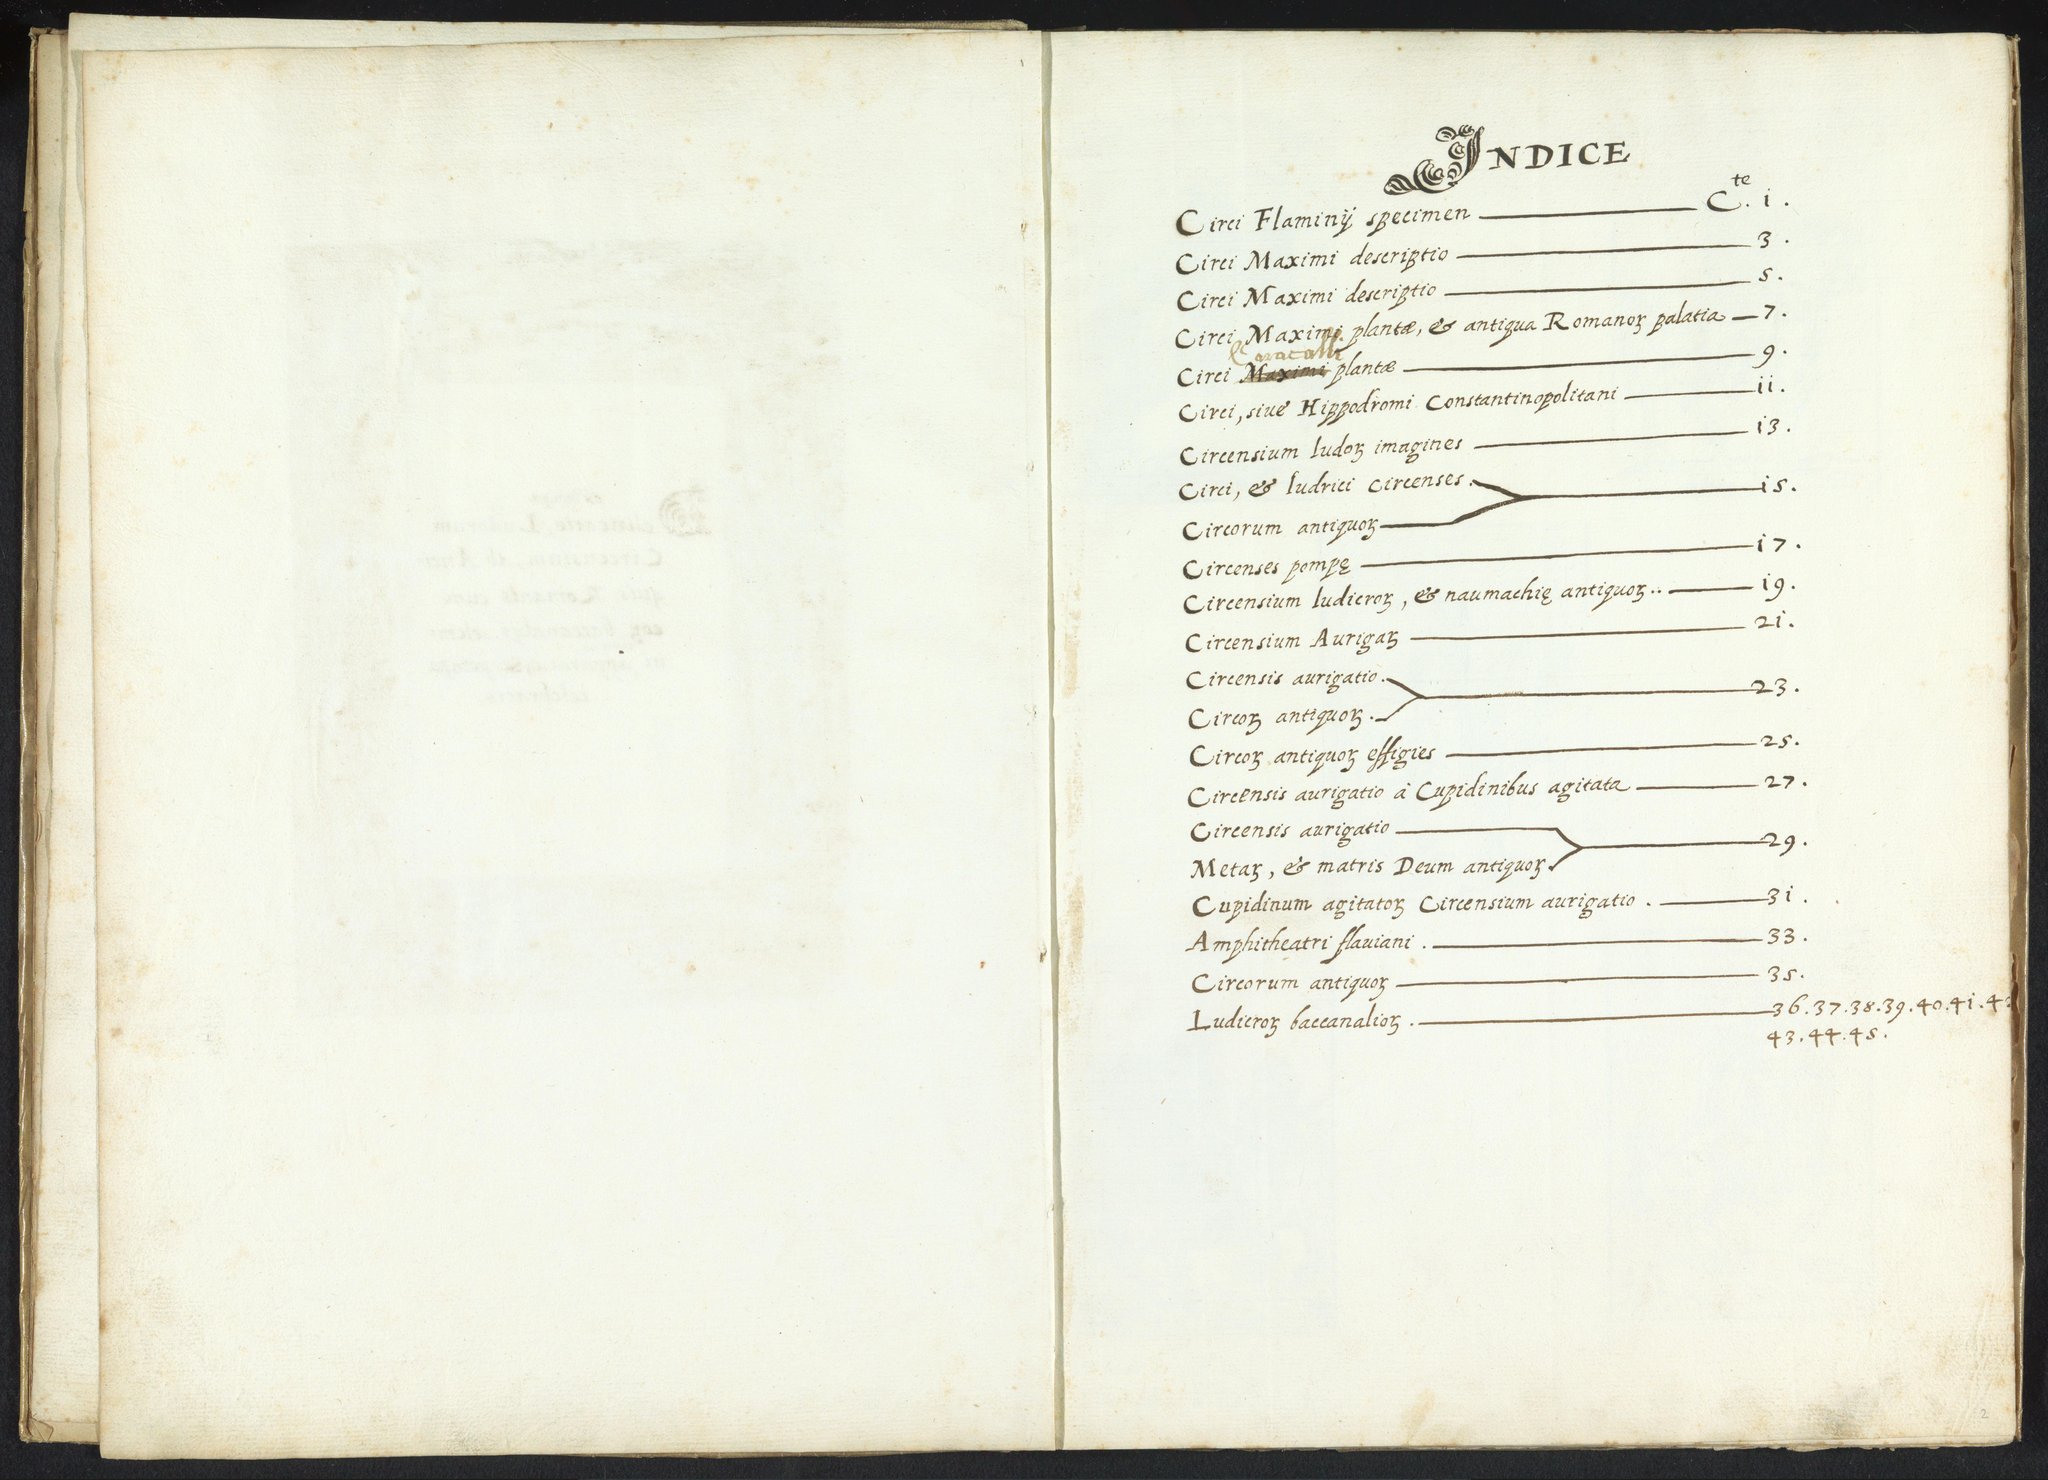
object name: album leaf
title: Geschreven register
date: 1642-1708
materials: ink, paper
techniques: pen, writing